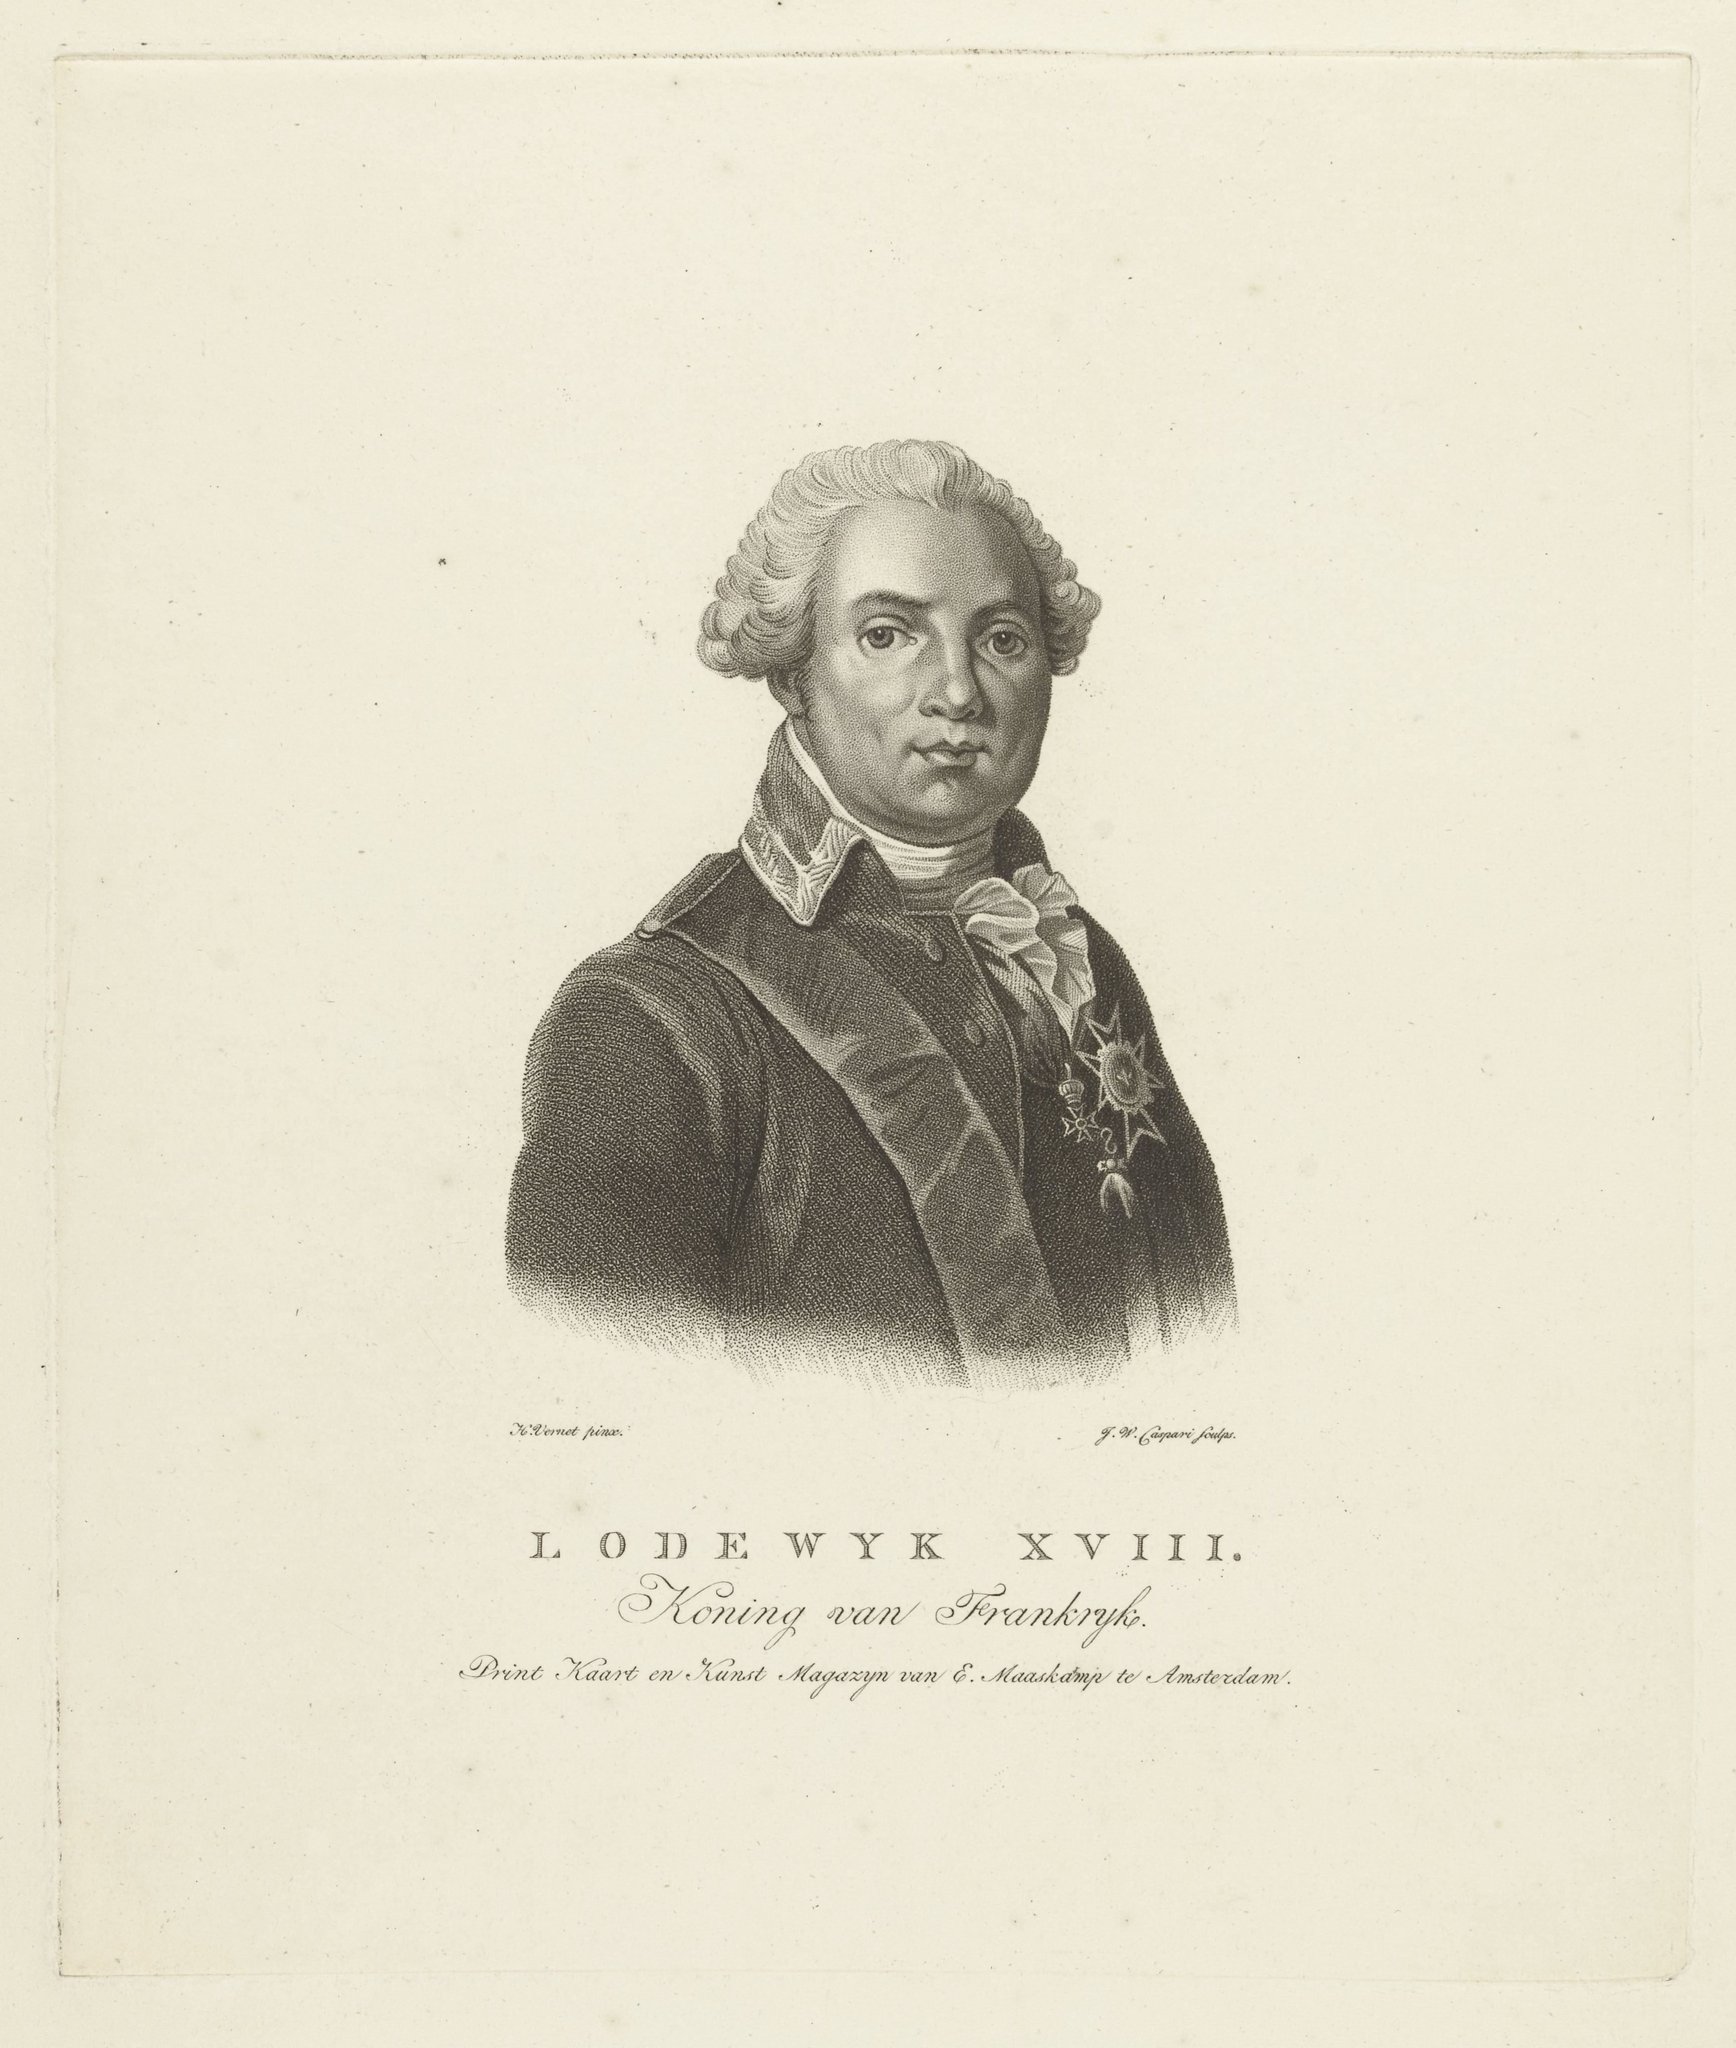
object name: print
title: Portret van Lodewijk XVIII, koning van Frankrijk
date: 1814-1822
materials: paper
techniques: etching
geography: amsterdam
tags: paris, lodewijk xviii (koning van frankrijk)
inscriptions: collector's mark: Lugt 2228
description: Portret van Lodewijk XVIII van Frankrijk. Buste naar rechts. De Franse koning draagt de ketting van het Gulden vlies en de ordester van de Heilige Geest. Onder het portret een Nederlands onderschrift met naam geportretteerde.